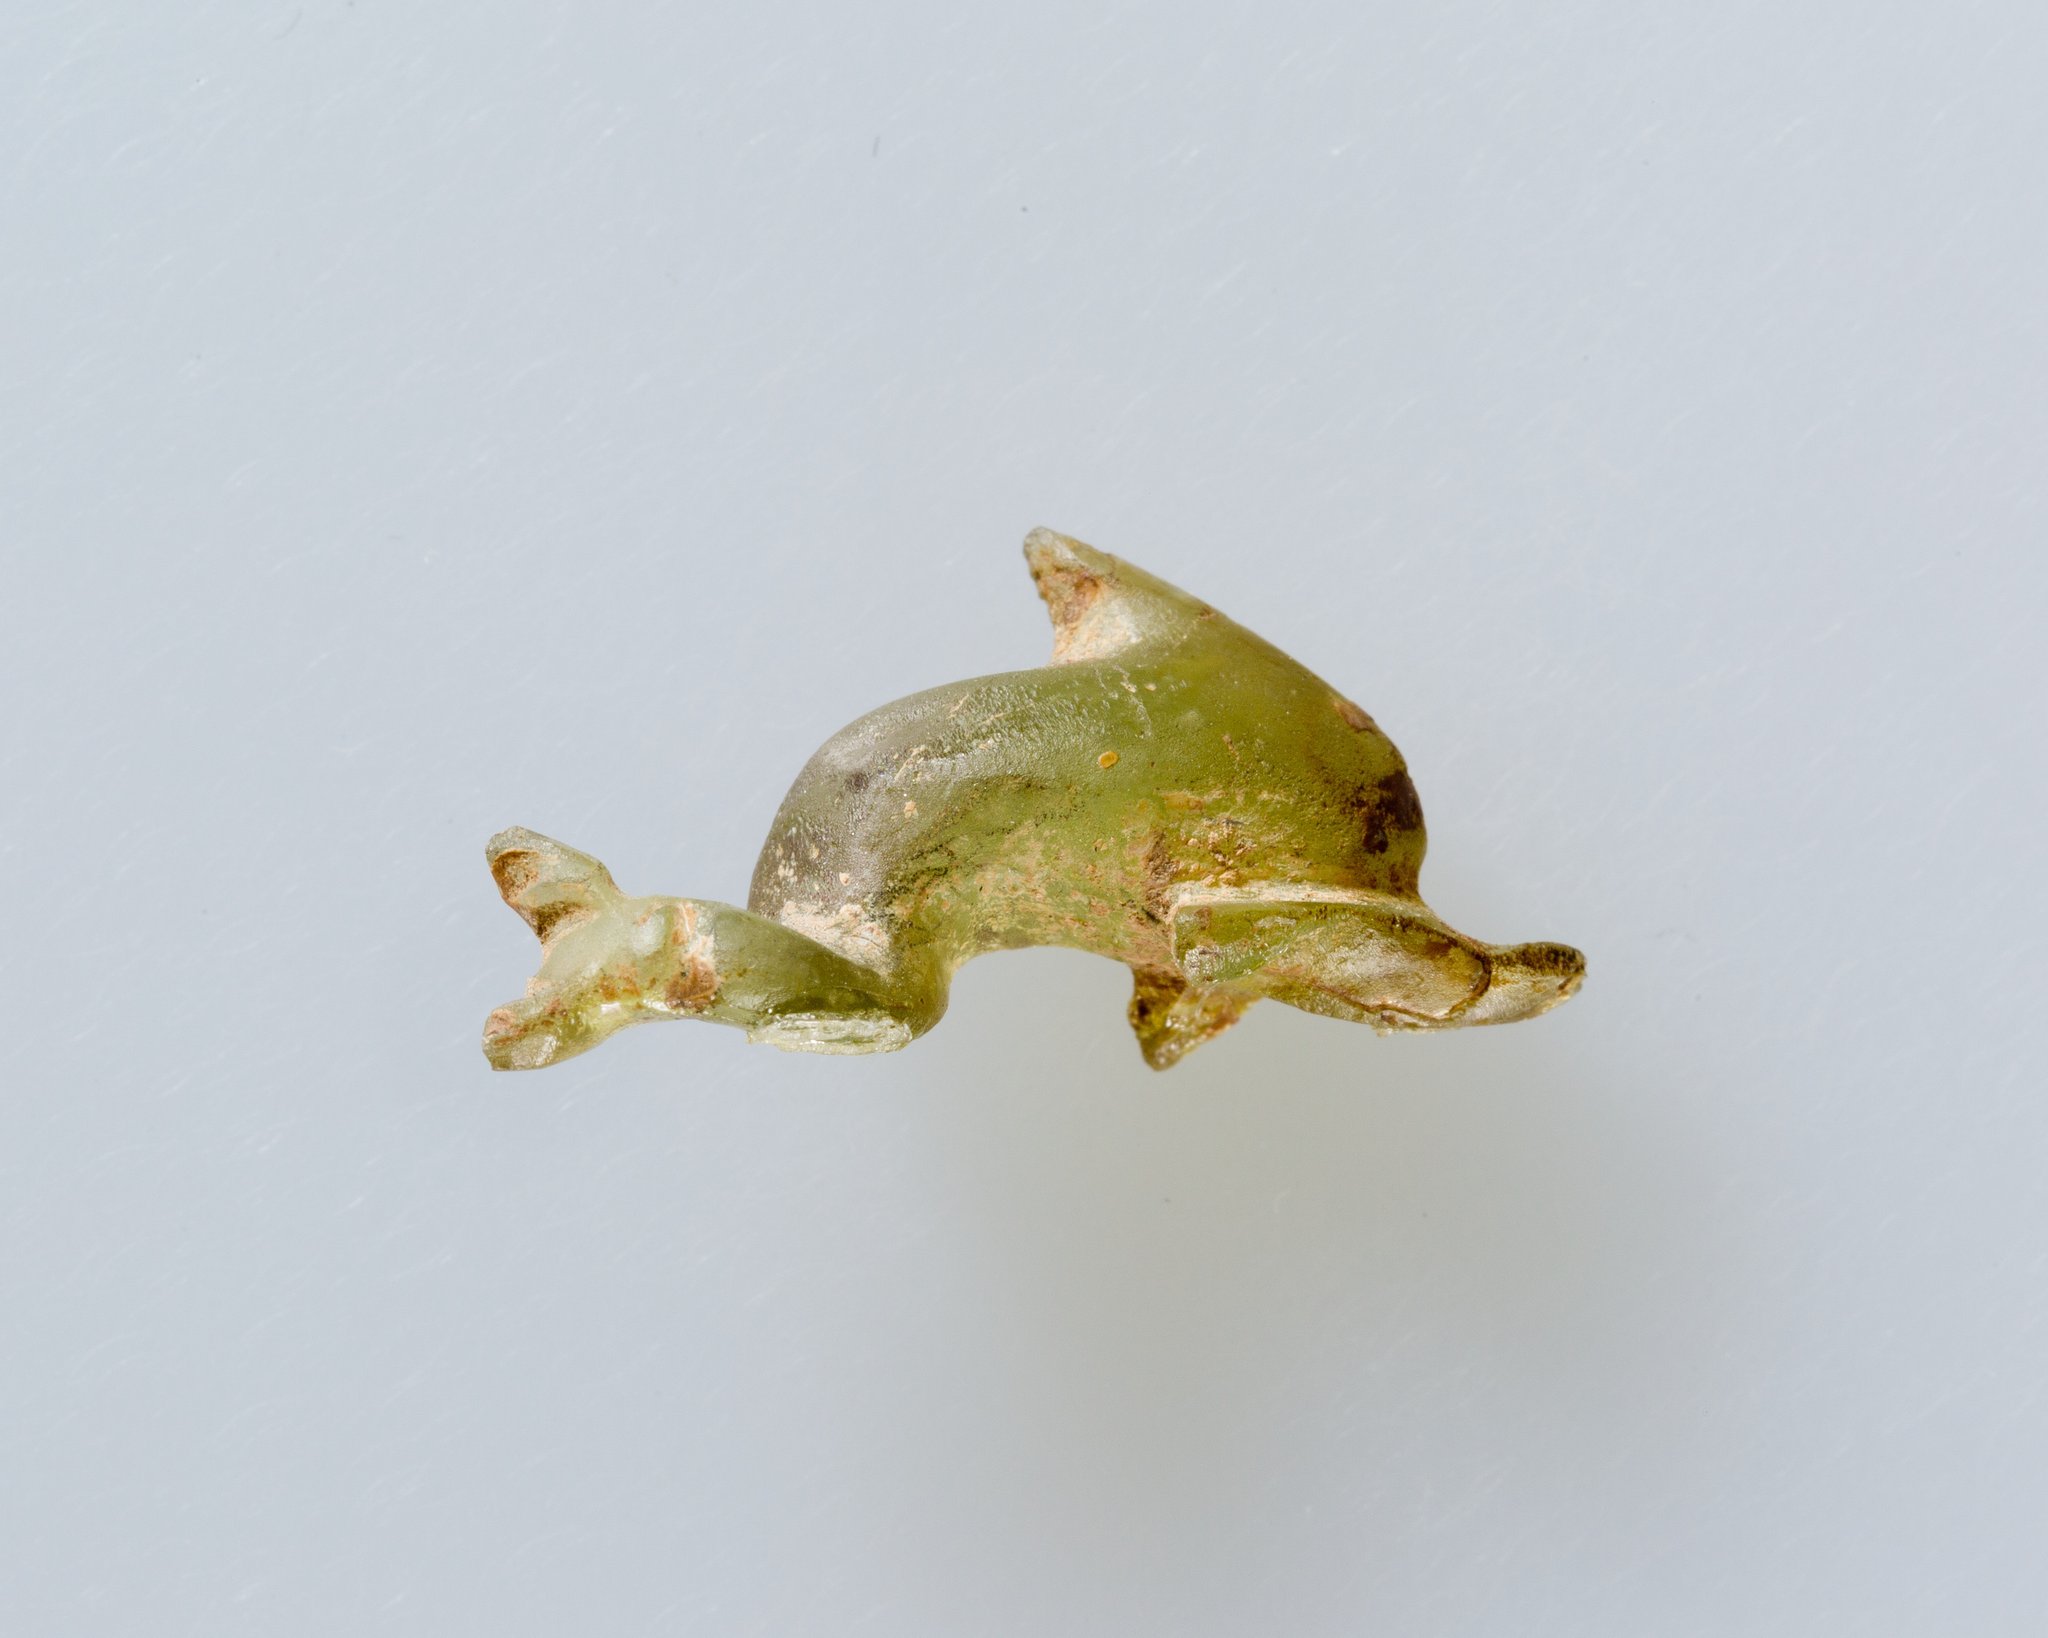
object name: amulet, fish dolphin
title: Dolphin amulet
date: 200 BCE-200 CE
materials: stone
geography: egypt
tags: dolphins